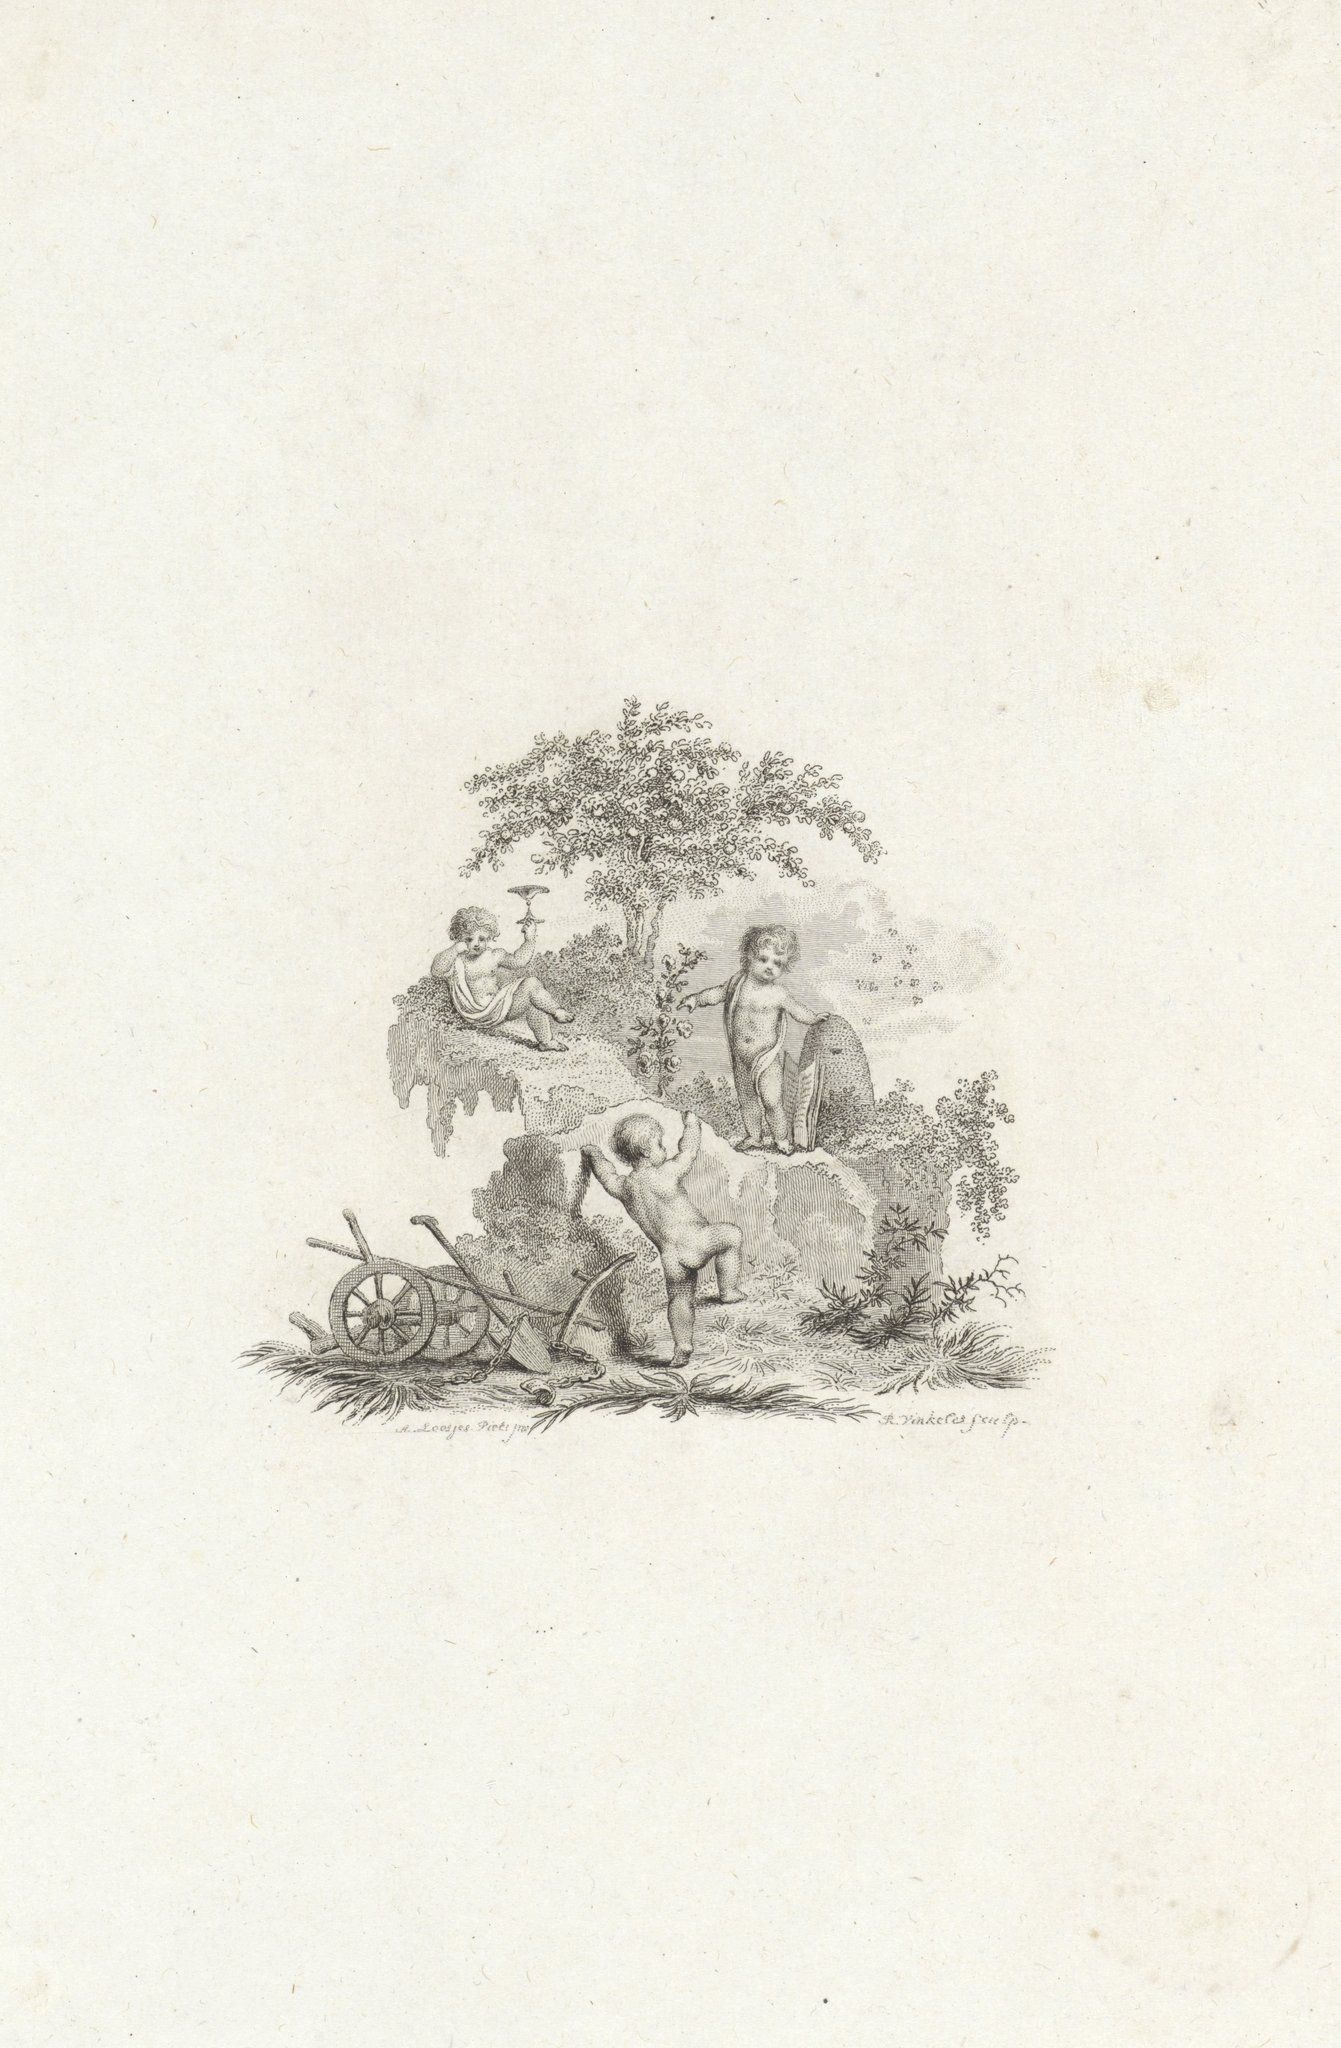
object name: print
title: Titelpagina voor: Adriaan Pietersz. Loosjes 'Rijkdom, middelbare stand en armoede', 1803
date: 1803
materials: paper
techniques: engraving, etching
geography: amsterdam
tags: bee-hive, agricultural implements: spade, cupids: 'amores', 'amoretti', 'putti'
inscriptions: collector's mark: Lugt 240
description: Titelpagina met drie putti met attributen in een berglandschap. Een putto staat bij landbouwwerktuigen, een andere staat naast een bijenkorf en de laatste heft zijn glas.